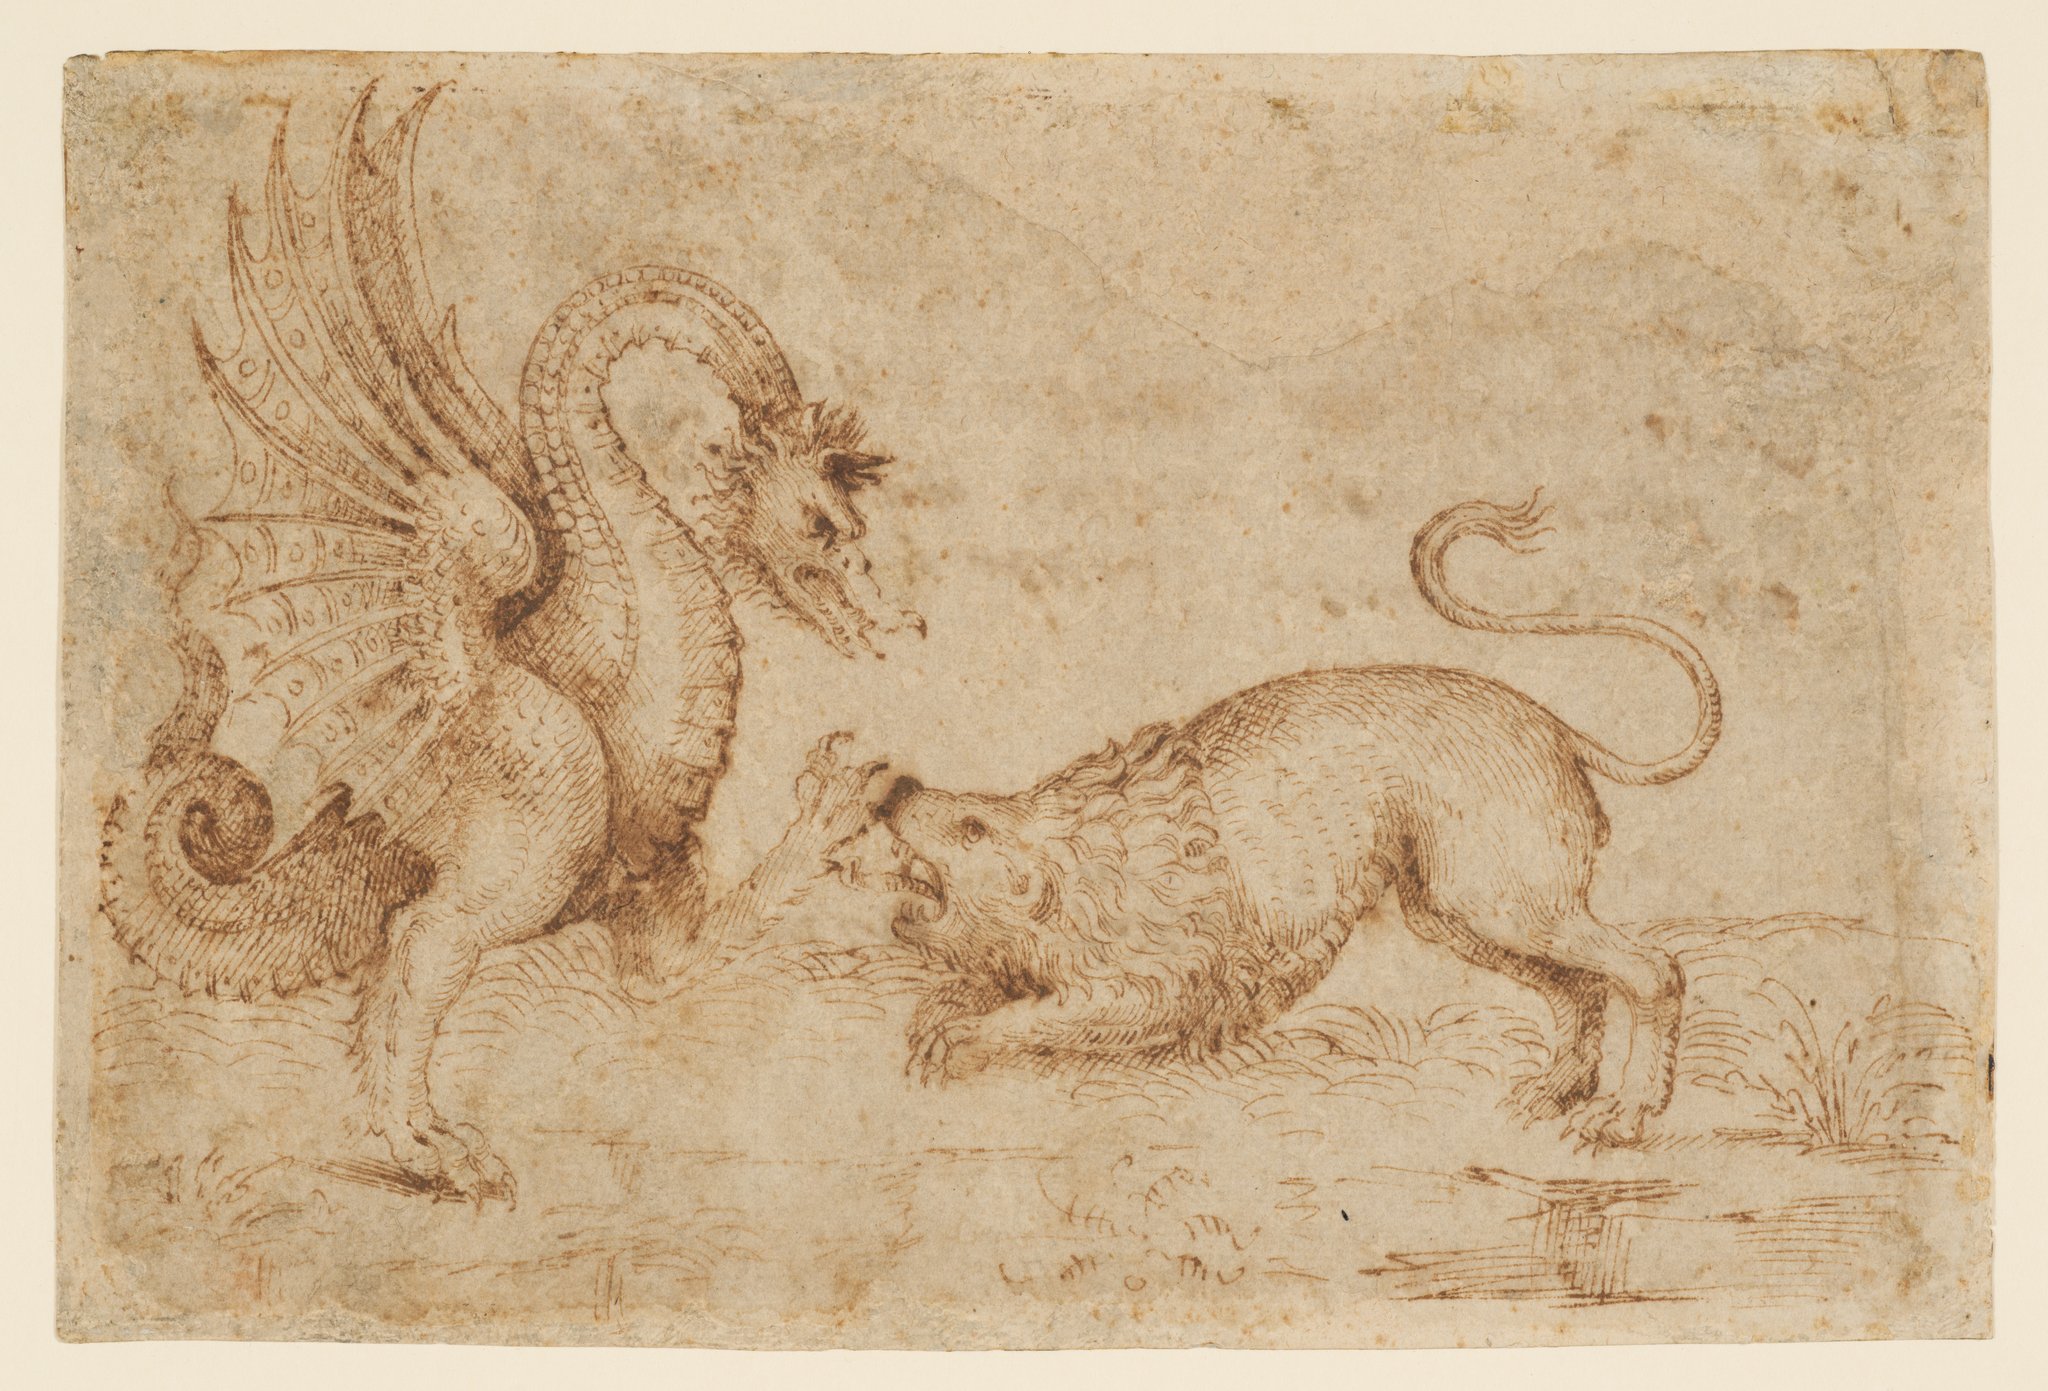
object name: drawing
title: A Lion Confronting a Dragon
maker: anonymous, italian, tuscan, 16th century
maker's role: artist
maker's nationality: italian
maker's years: 1500-1600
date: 1500-1510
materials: ink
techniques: pen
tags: dragons,lions